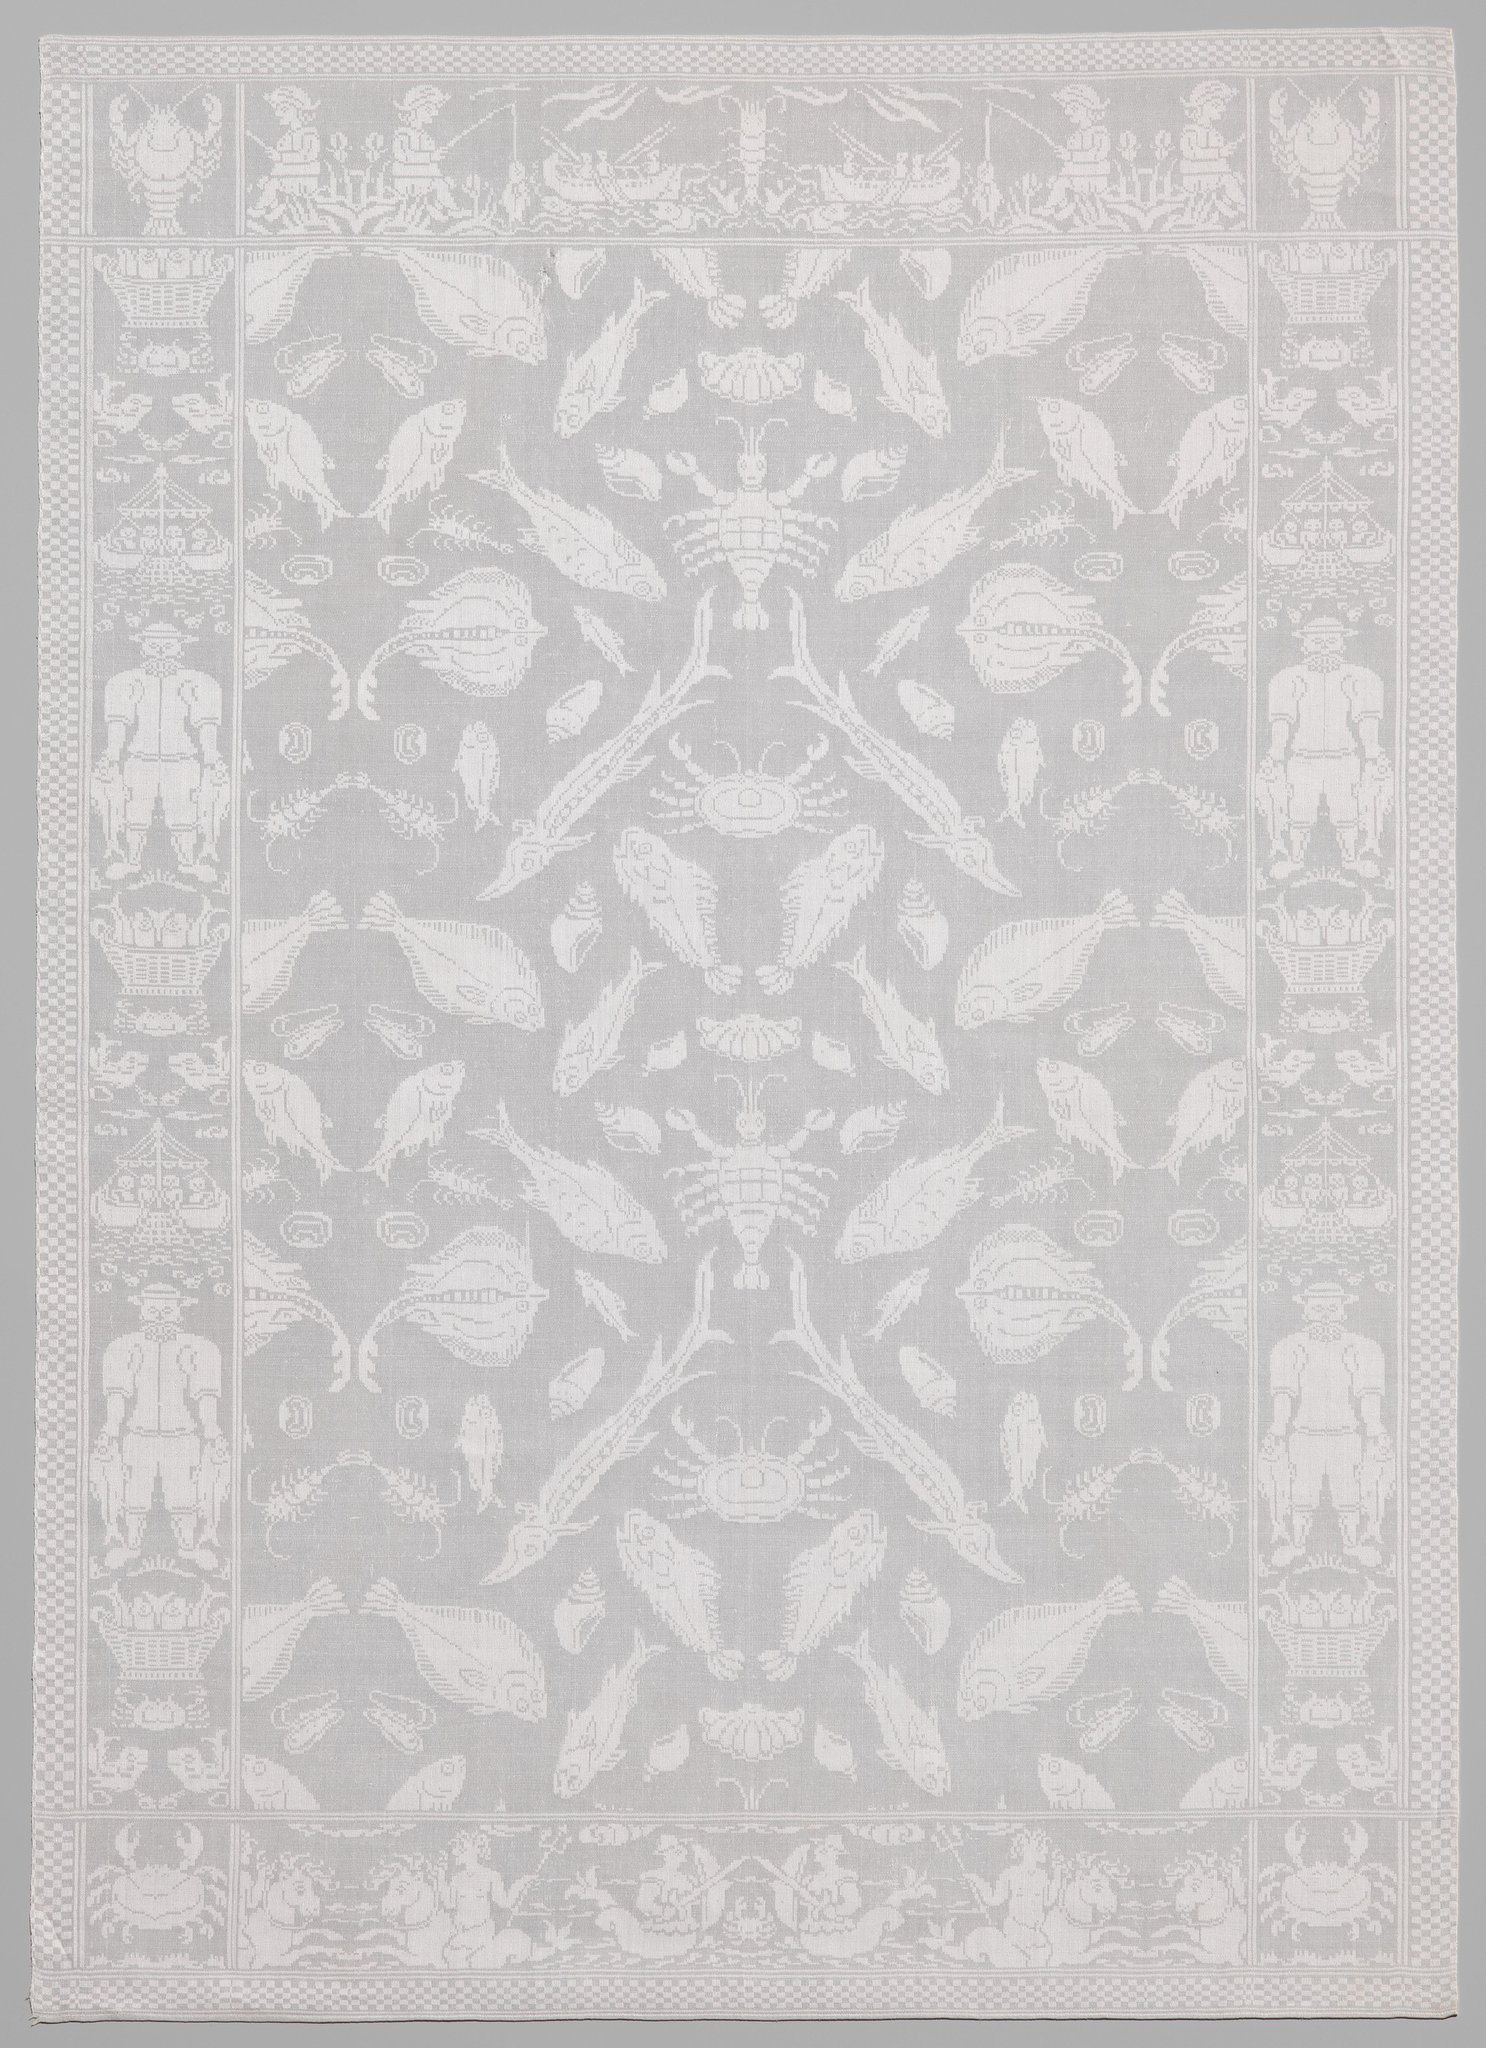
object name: napkin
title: Servet met vissen en schaaldieren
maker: Anonymous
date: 1600-1649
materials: linen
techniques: damask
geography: haarlem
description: Servet van linnendamast met vissen en schaaldieren. Middenveld: diverse vissen. Staande randen: vissen en visvangst. Liggende randen: zeegoden. Hoek: krab.